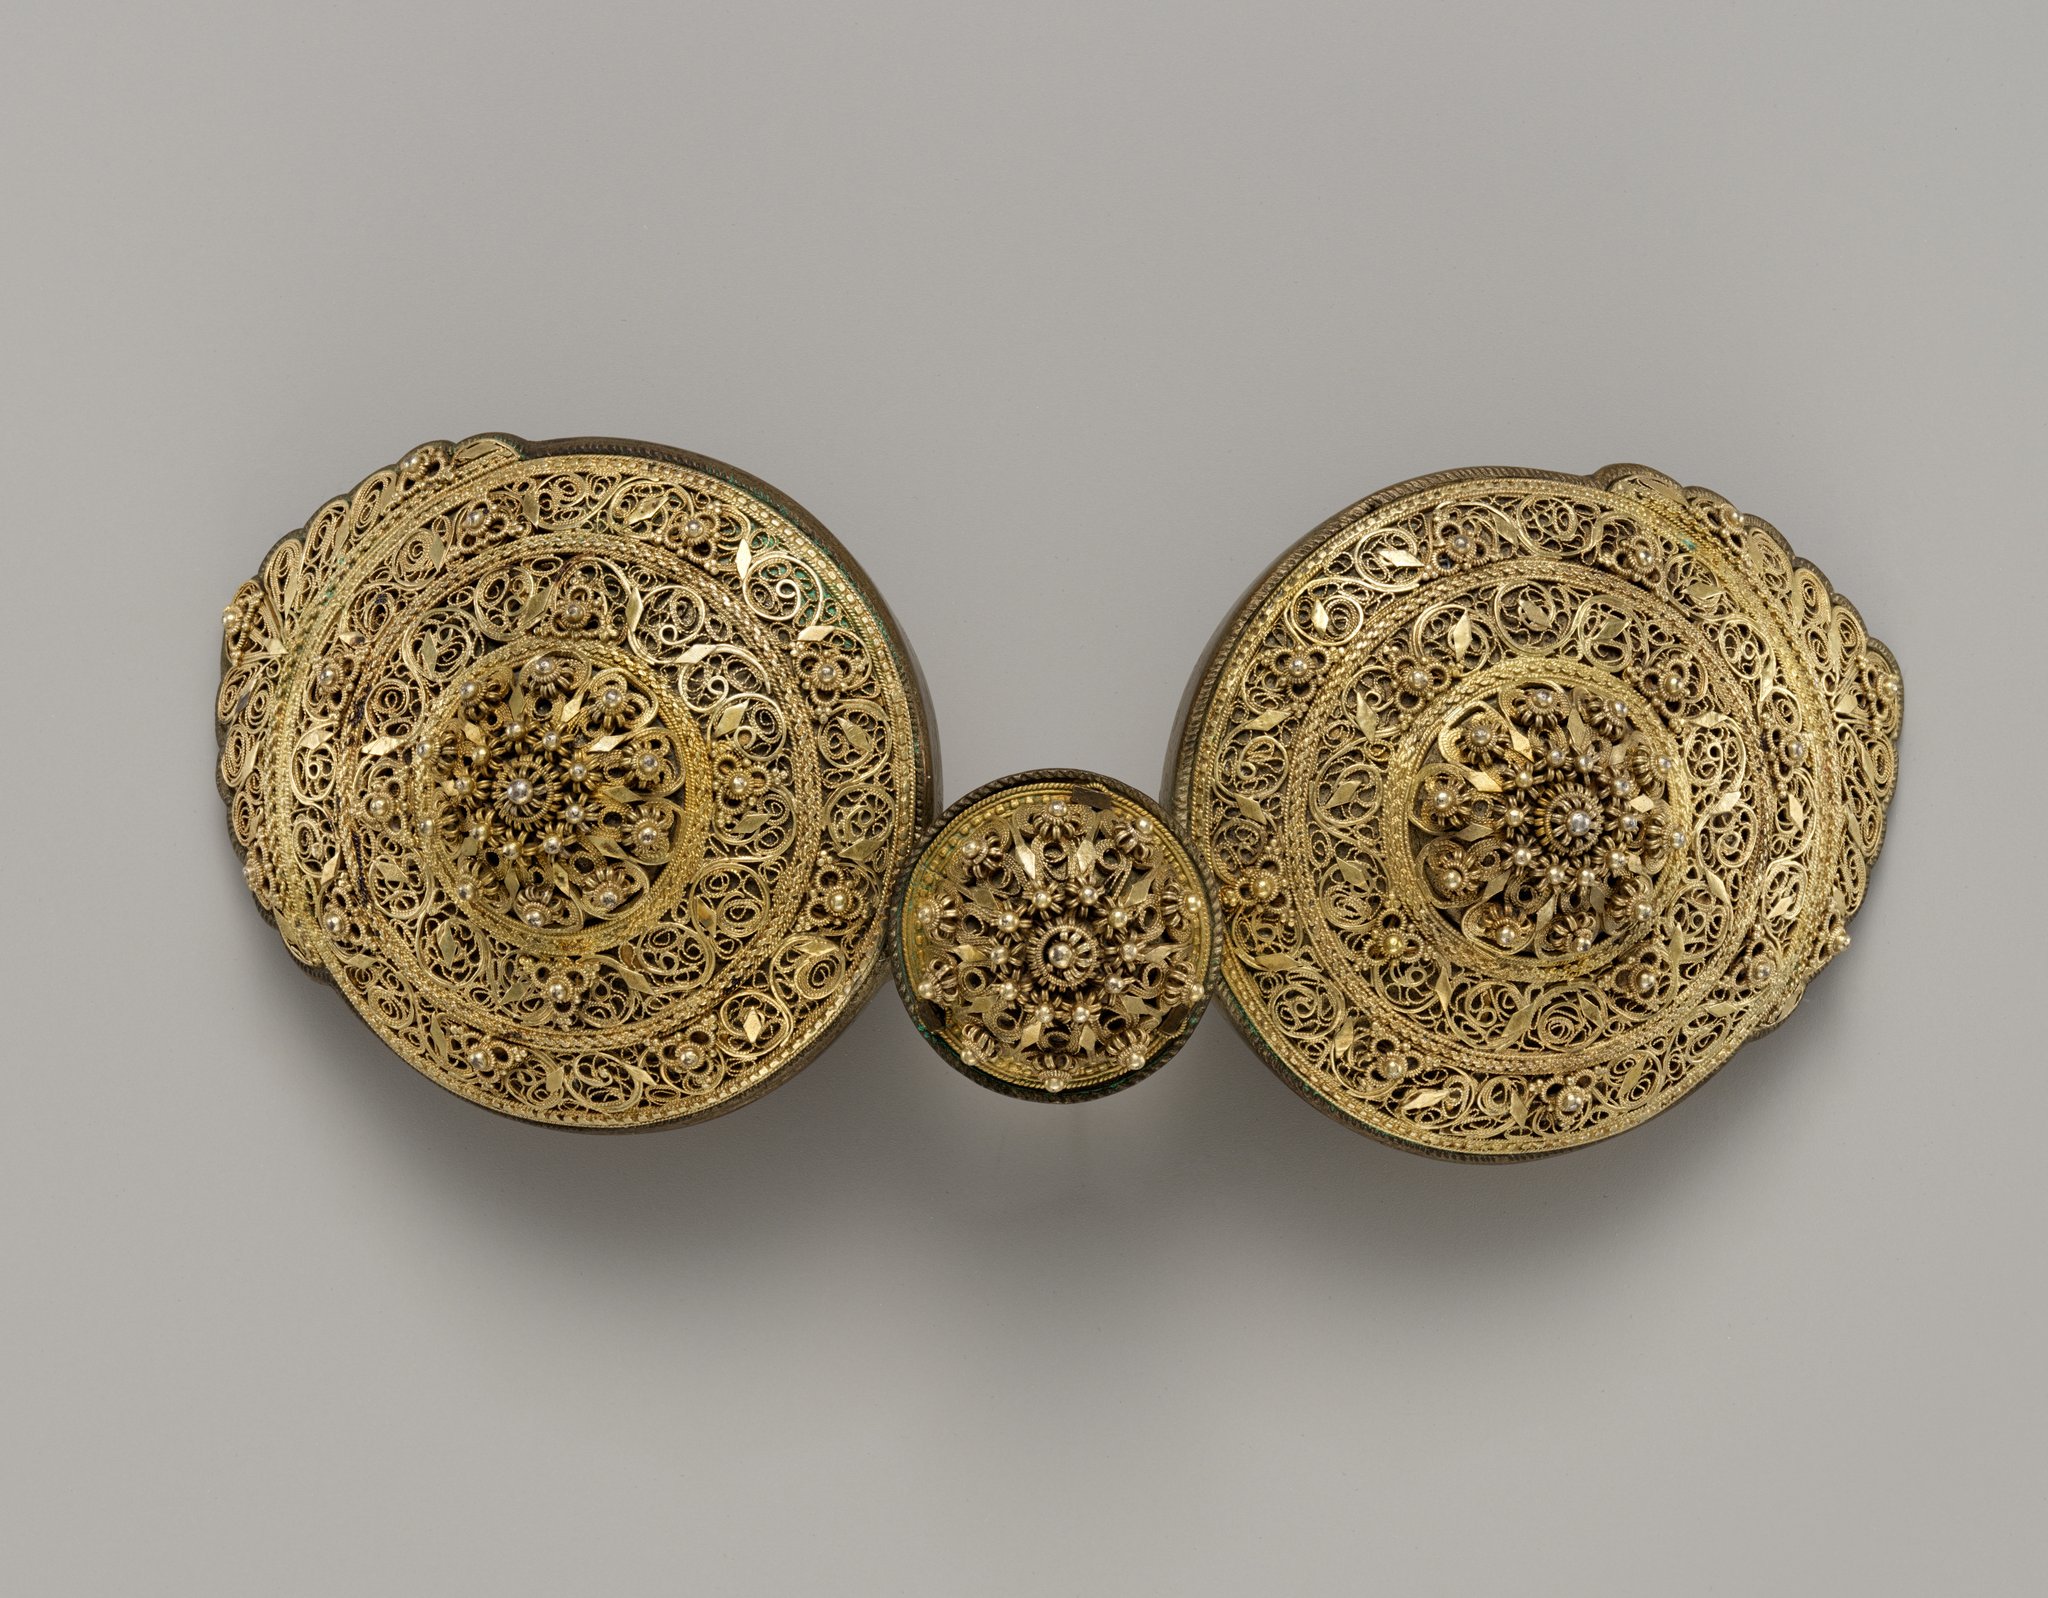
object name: girdle clasp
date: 1801-1900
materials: alloy, gilt, silver, metal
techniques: filigree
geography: balkans